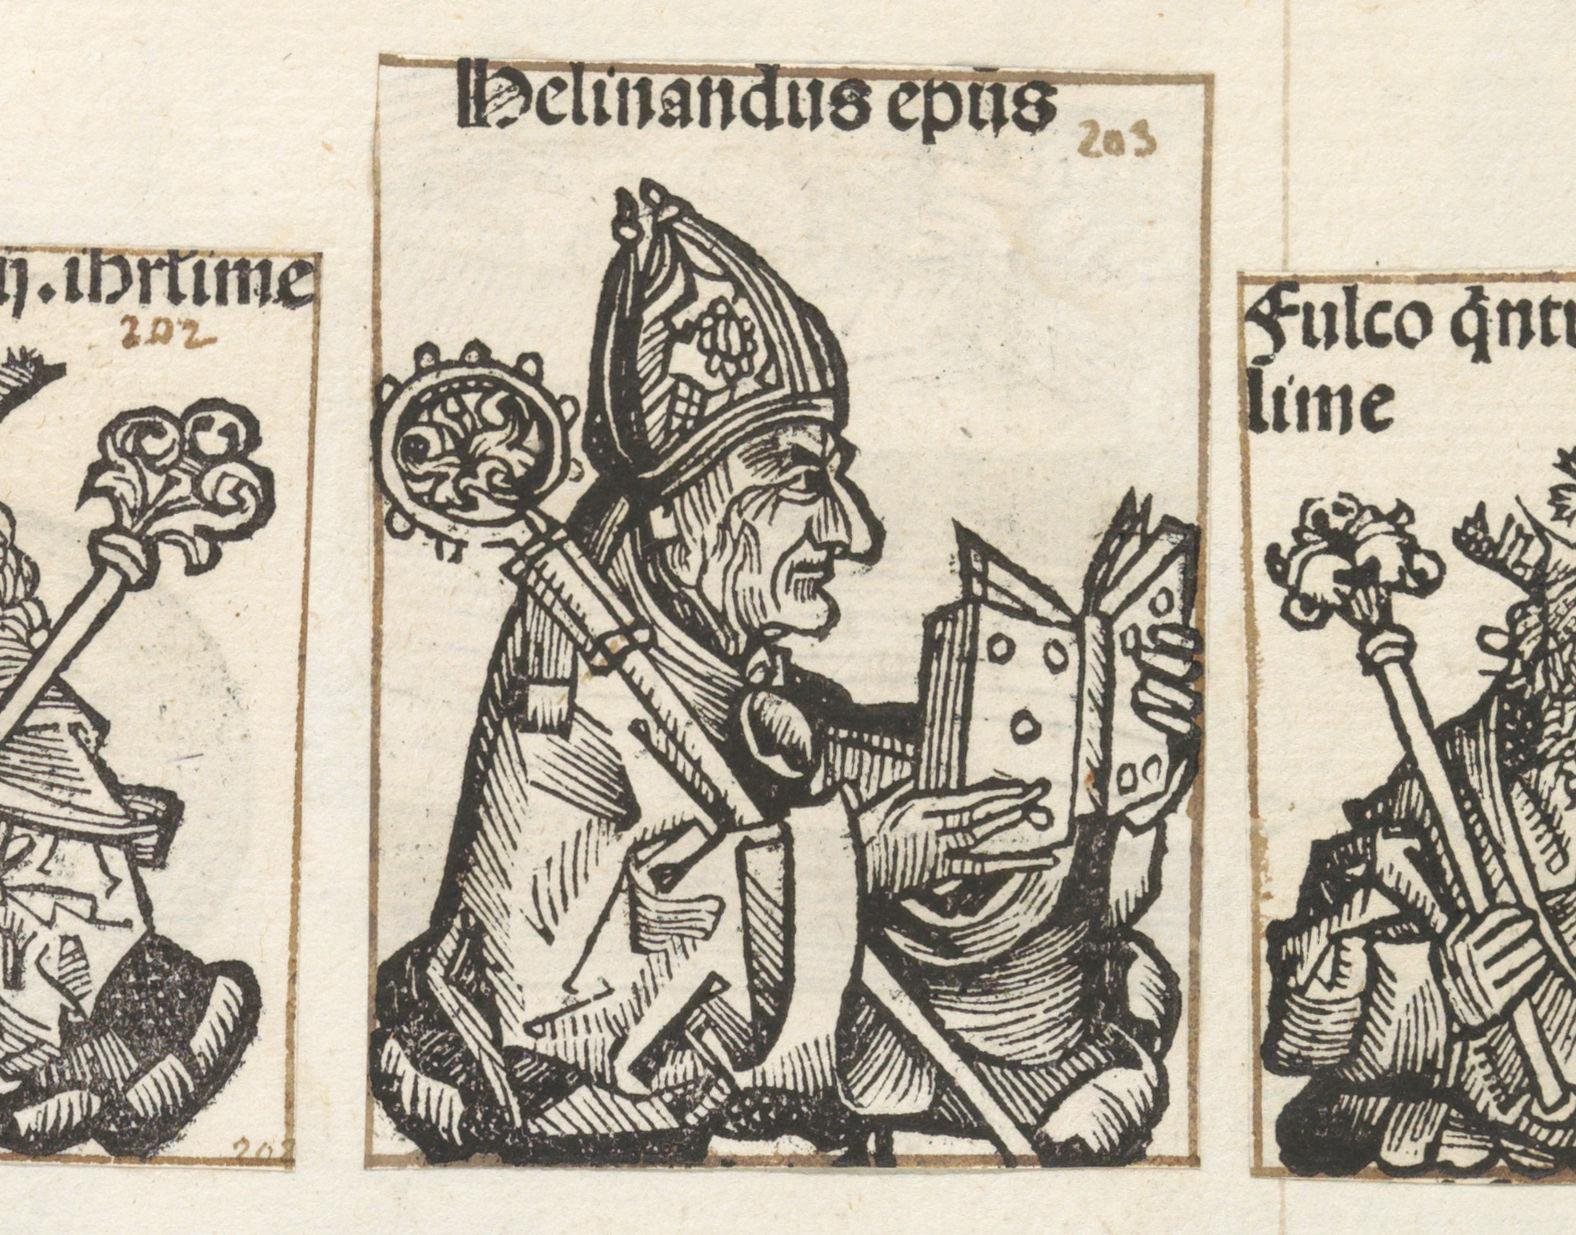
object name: album leaf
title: Liber Chronicarum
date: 1493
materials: paper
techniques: letterpress printing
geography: nuremberg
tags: archbishop, bishop, etc. (roman catholic)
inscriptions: inscription: ‘203’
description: De houtsnede wordt herhaaldelijk gebruikt als boekillustratie in de Liber Chronicarum (of Neurenbergkroniek) van Hartmann Schedel, verschenen in het Latijn en Duits in 1493. Zie de Latijnse uitgave, folio 199r.